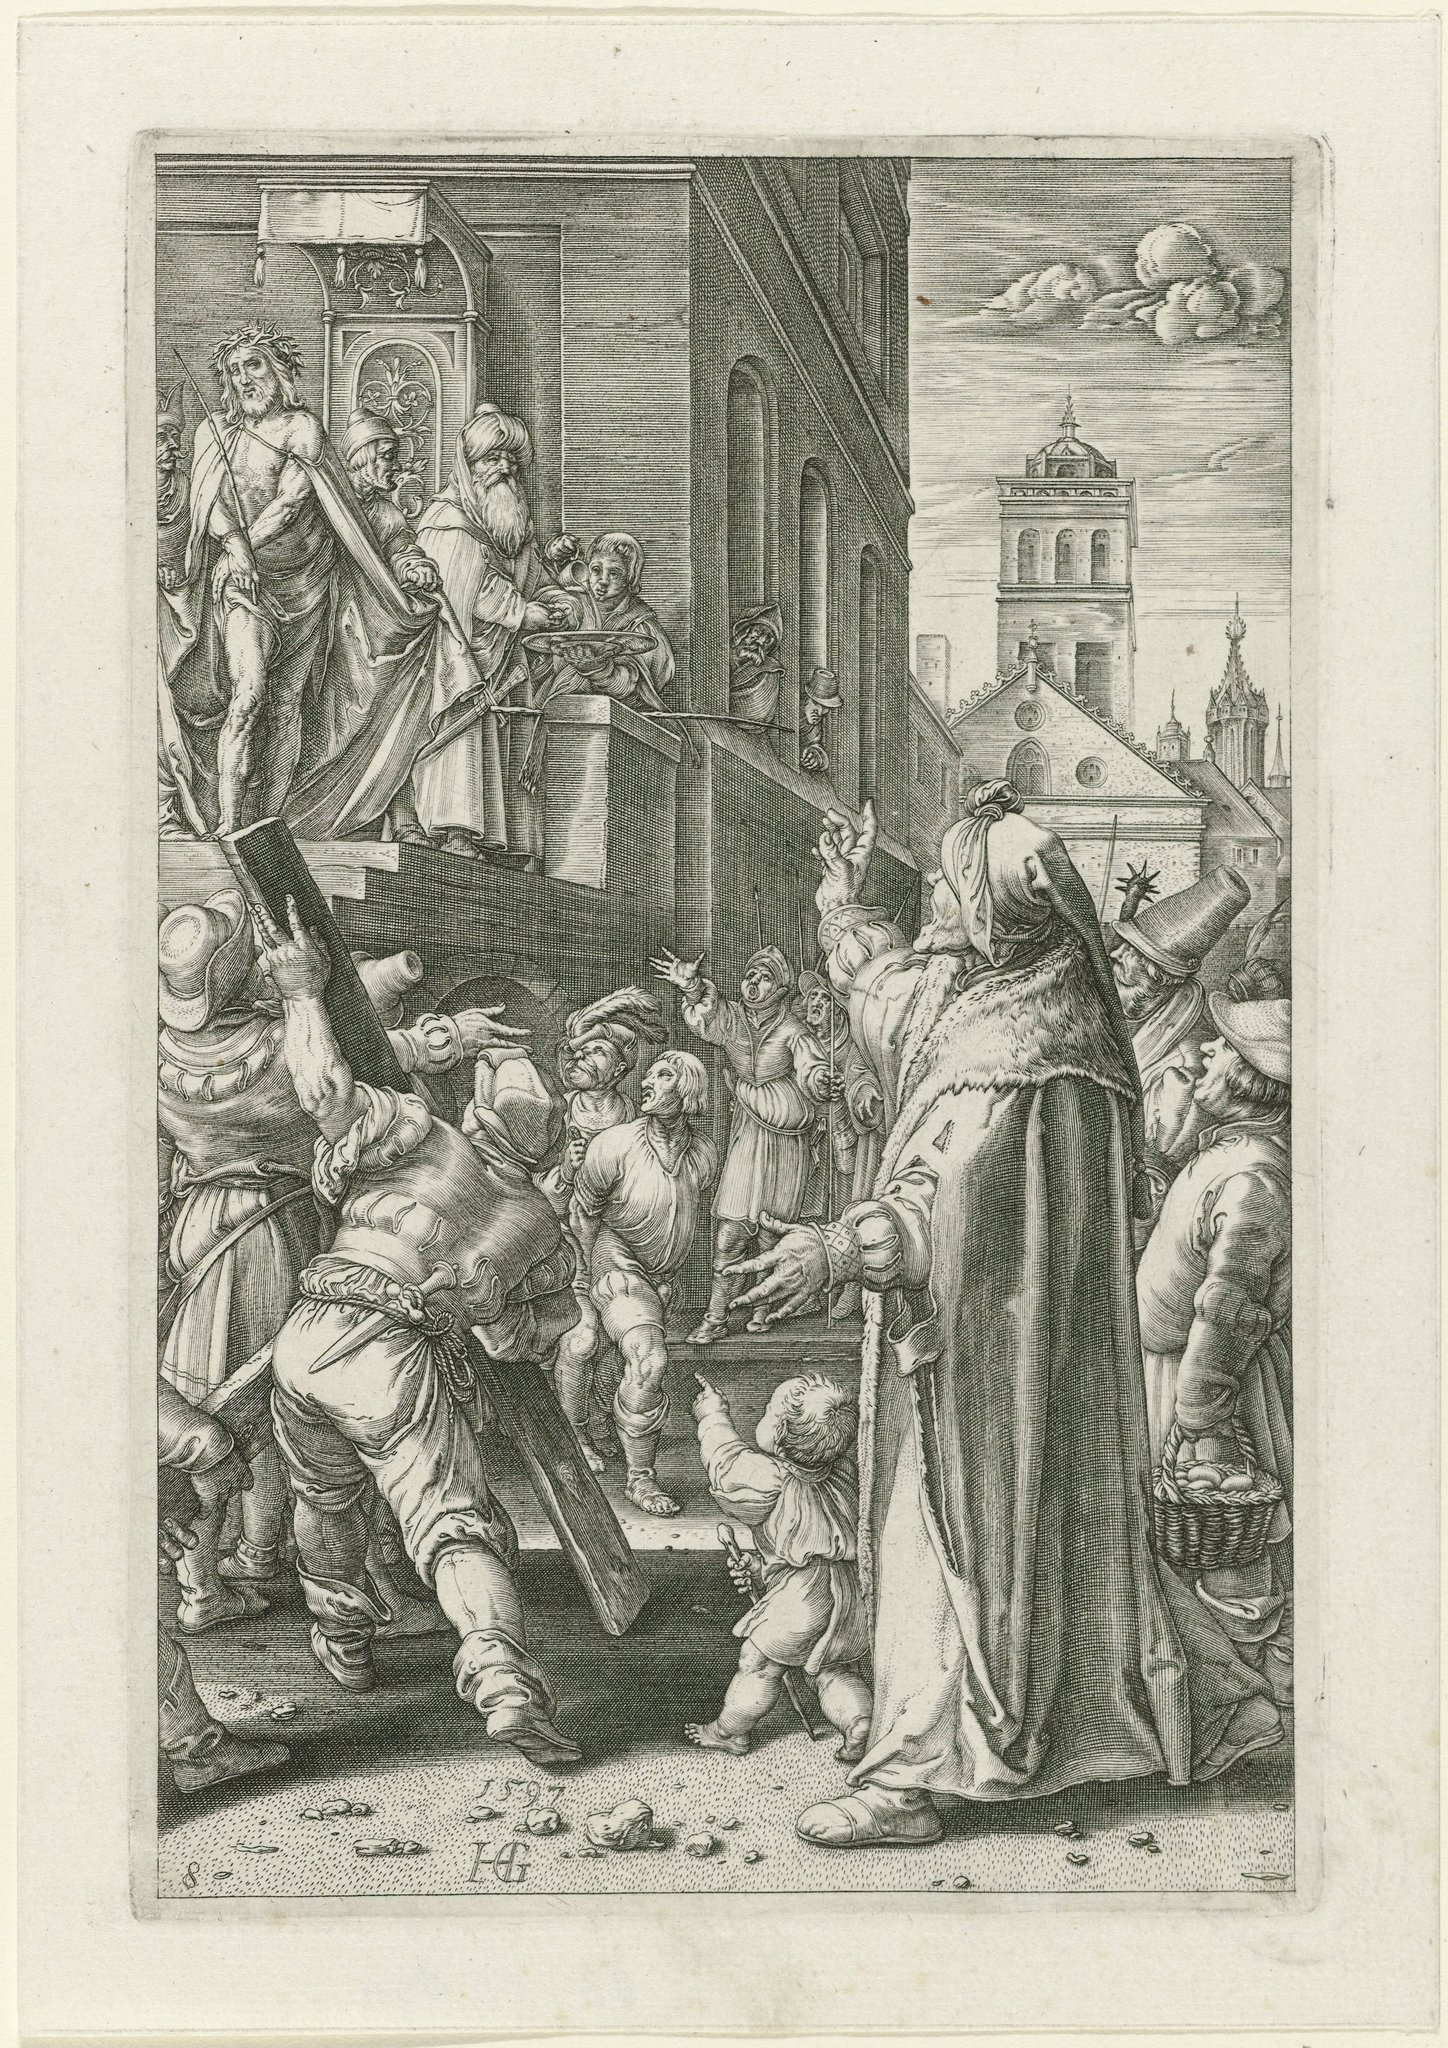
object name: print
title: Christus aan het volk getoond (Ecce Homo)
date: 1597-1667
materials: paper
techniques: engraving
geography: netherlands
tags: pilate washing his hands (in innocence), pilate showing christ to the people, 'ostentatio christi', 'ecce homo' (john 19:4-6)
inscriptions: collector's mark: Lugt 240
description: Christus wordt door Pilatus op een podium aan het volk getoond. Pilatus heeft aan het volk gevraagd of hij Christus of Barabbas zal vrij laten. Het volk roept dat Barabbas moet worden vrijgelaten, wat in het midden gebeurt, en dat Christus moet worden gekruisigd. Pilatus wast zijn handen in onschuld.